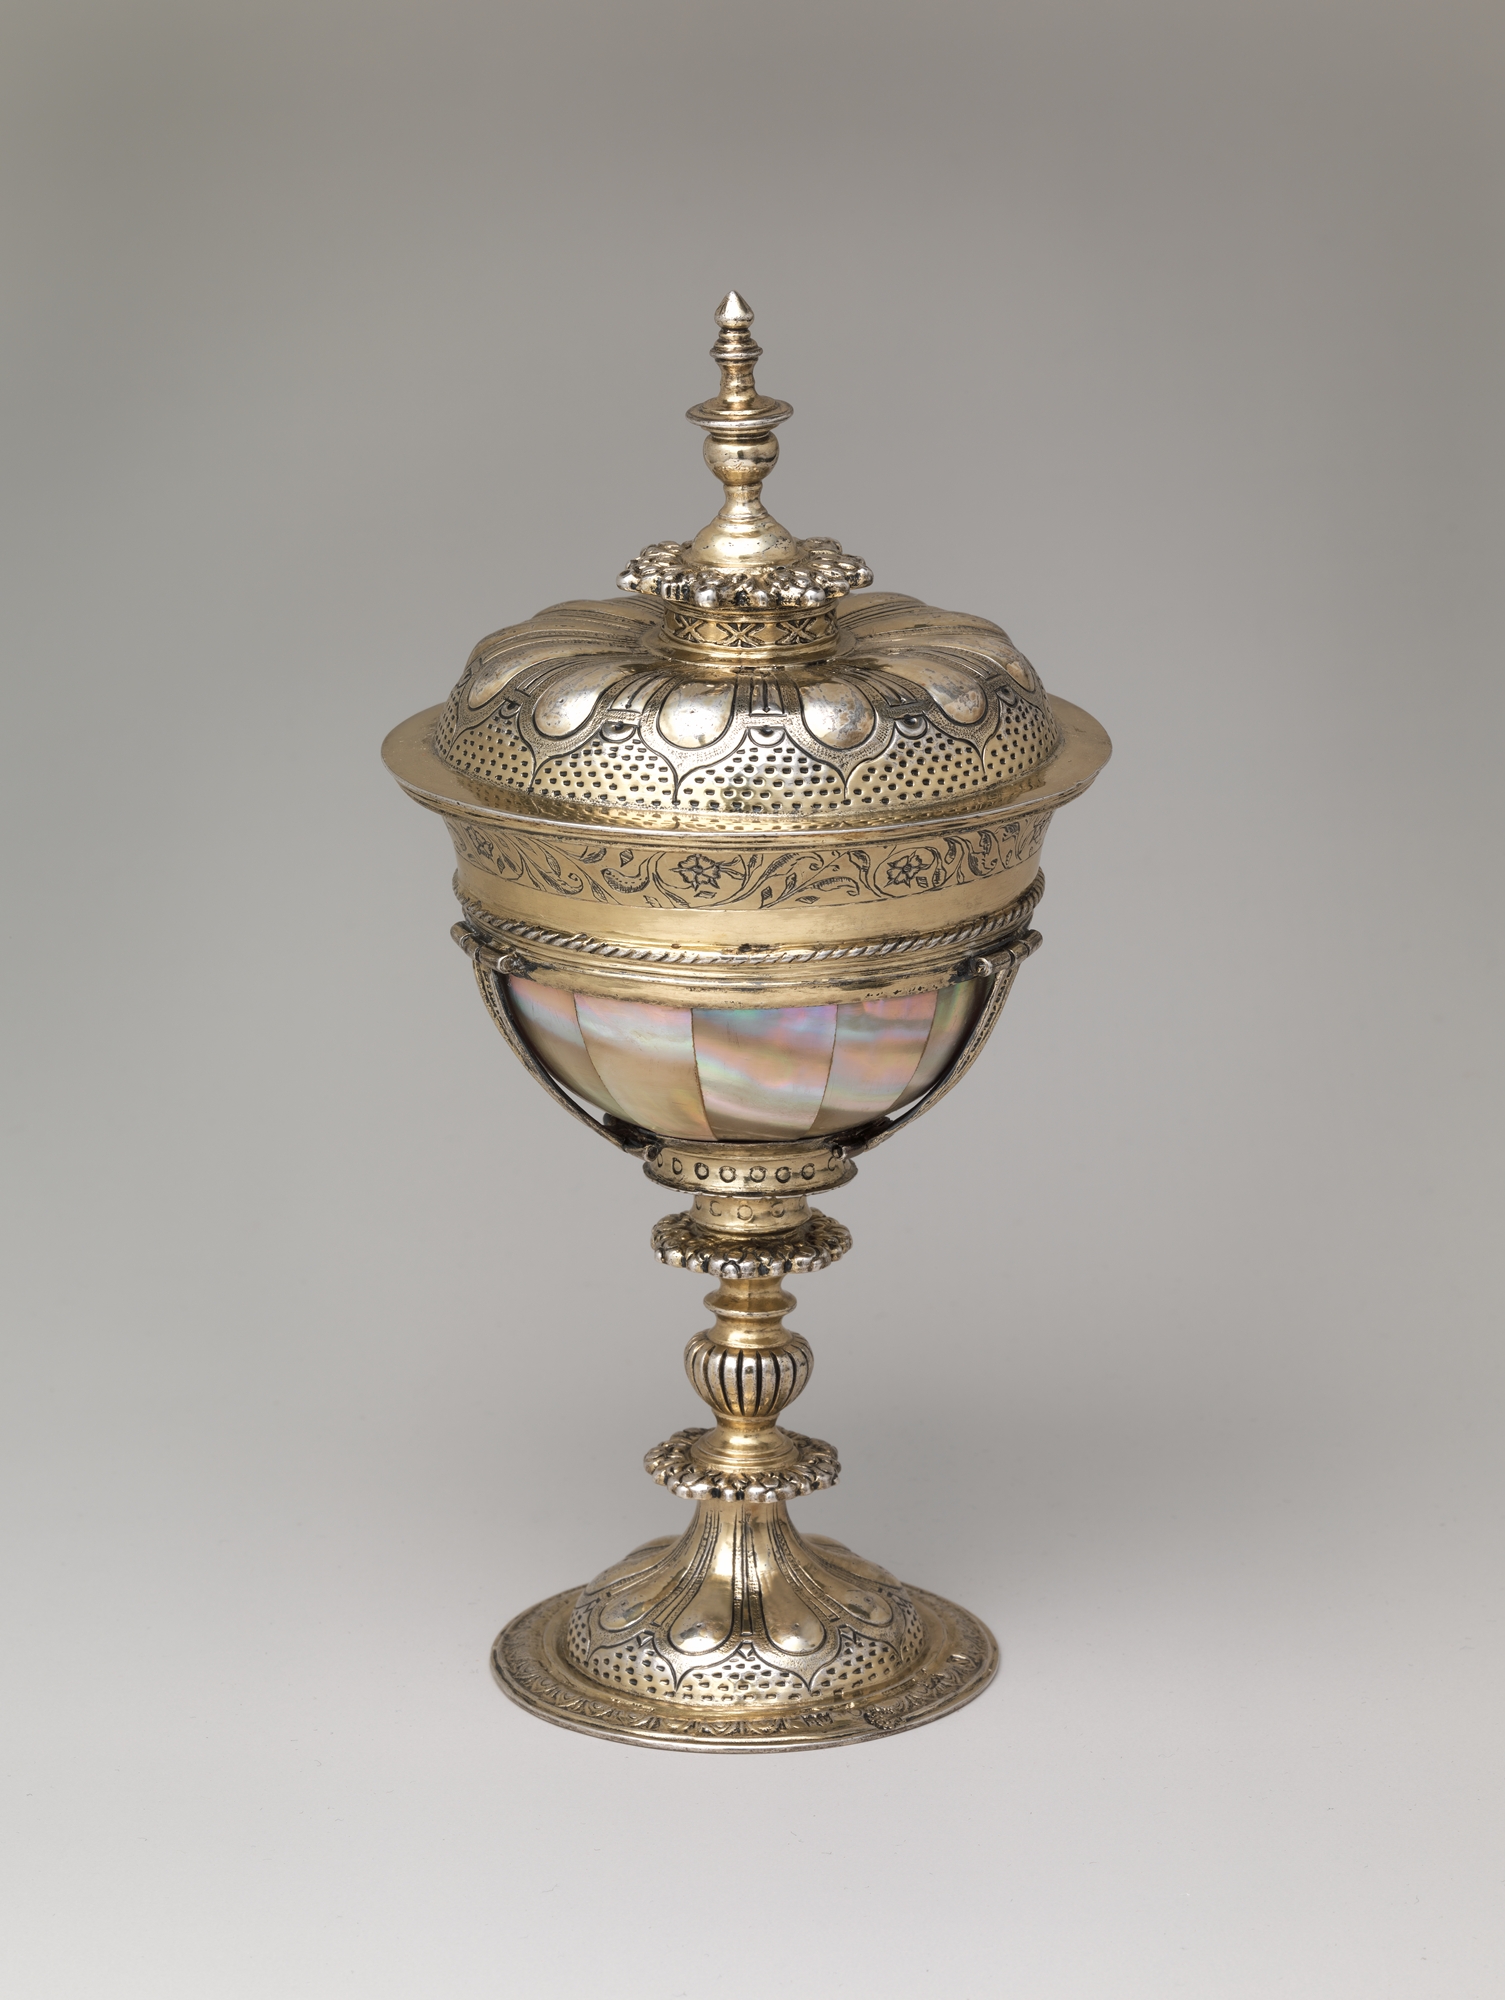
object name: cup with cover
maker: r w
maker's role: maker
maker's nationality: british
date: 1590-1591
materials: gilt silver, mother of pearl